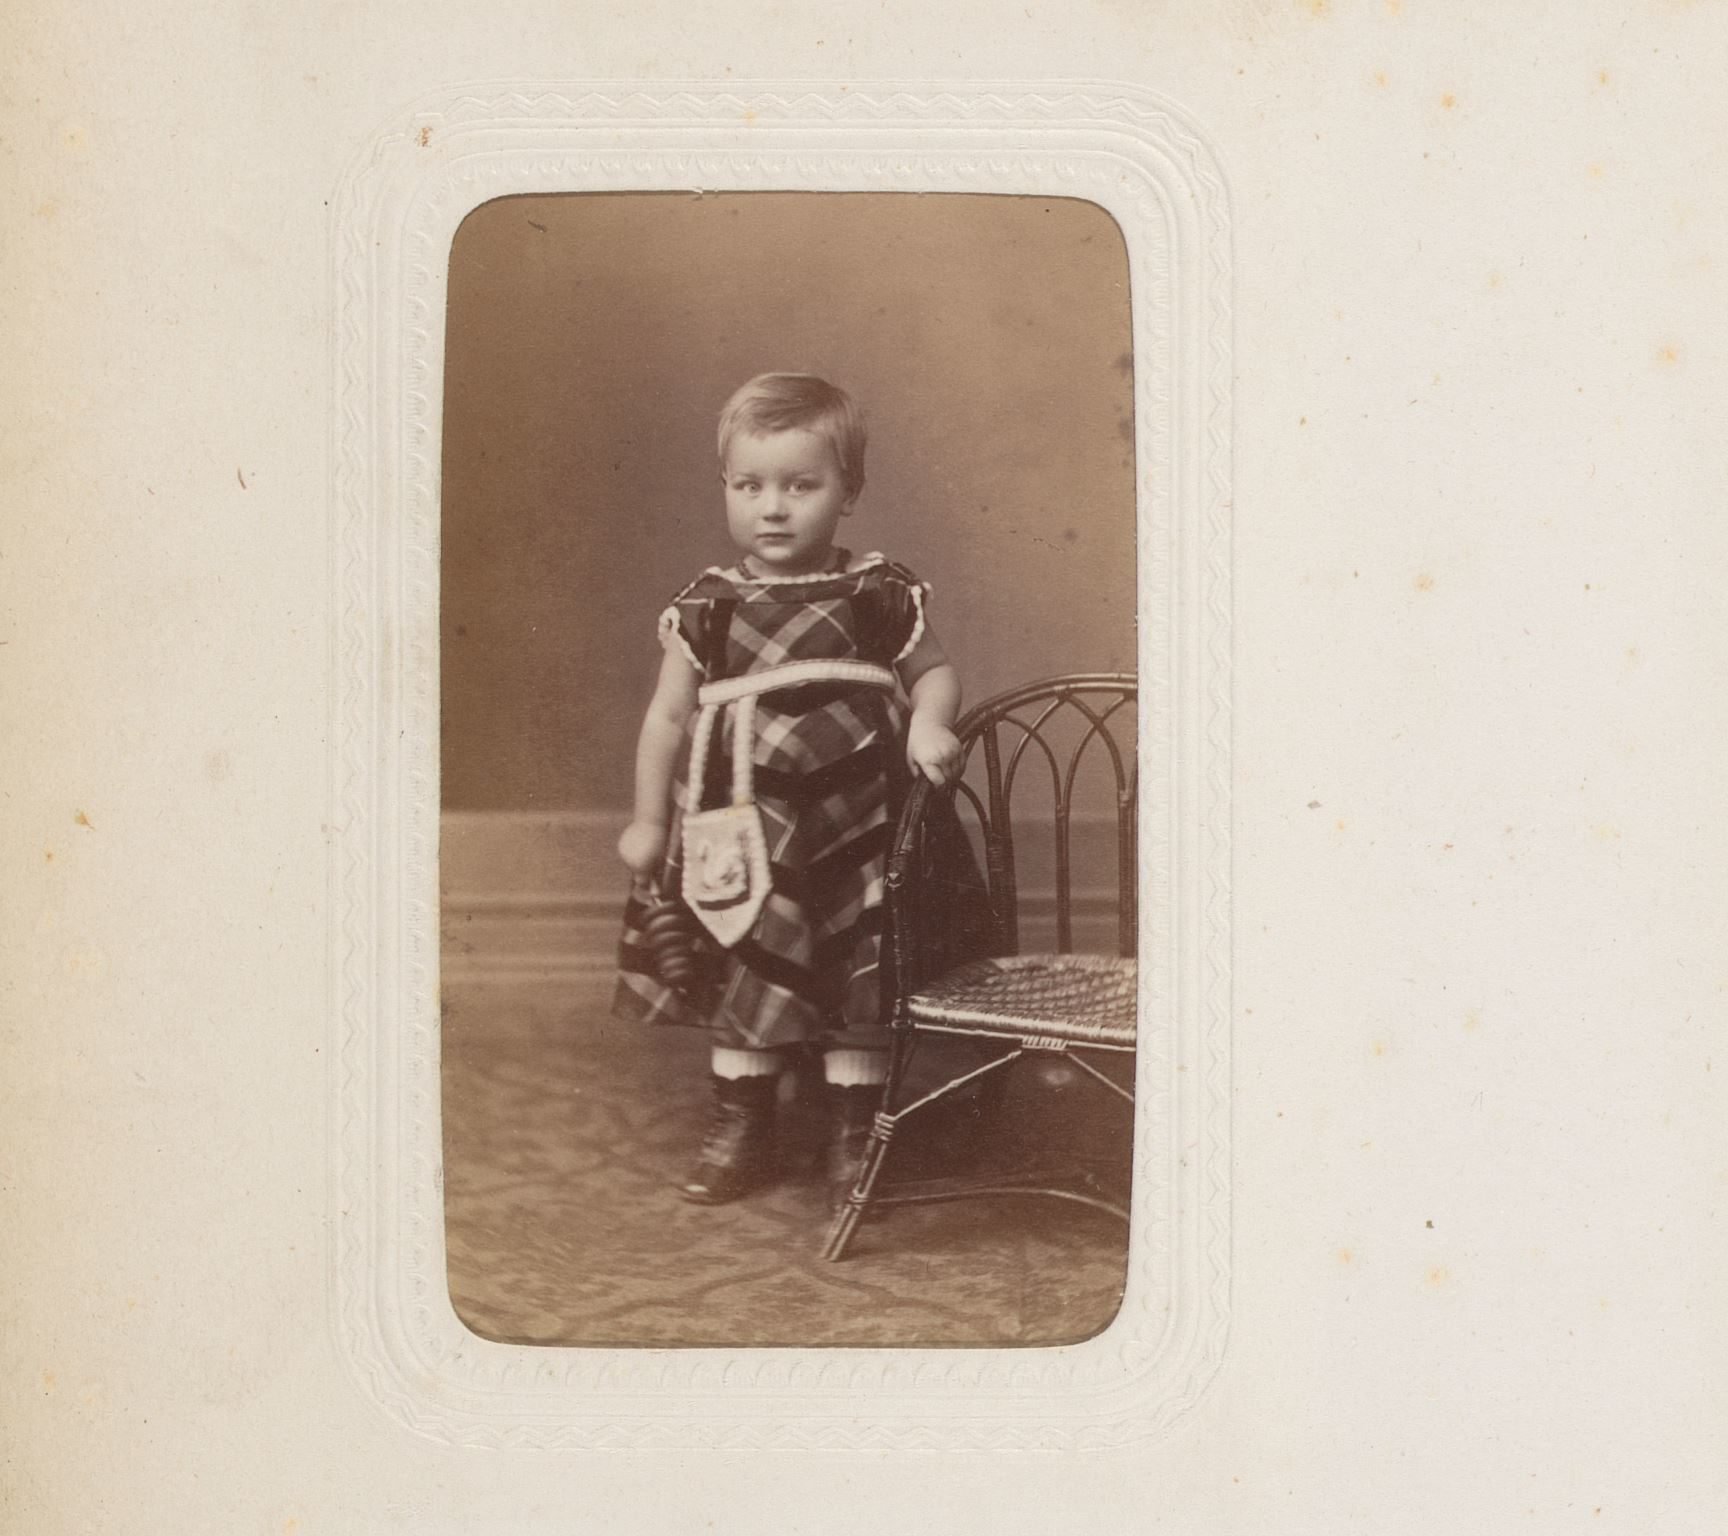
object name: carte de visite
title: Portret van een meisje bij een stoel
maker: ernst wolffram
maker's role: fotograaf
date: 1850-1900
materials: cardboard, photographic support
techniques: albumen print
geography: bremen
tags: historical persons - bb - woman, toddler (female), chair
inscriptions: inscription: ‘(...)/ E. WOLFFRAM/ PHOTOGR. ATELIER/ BREMEN/ Fedelhören 14./ PARTERRE.’